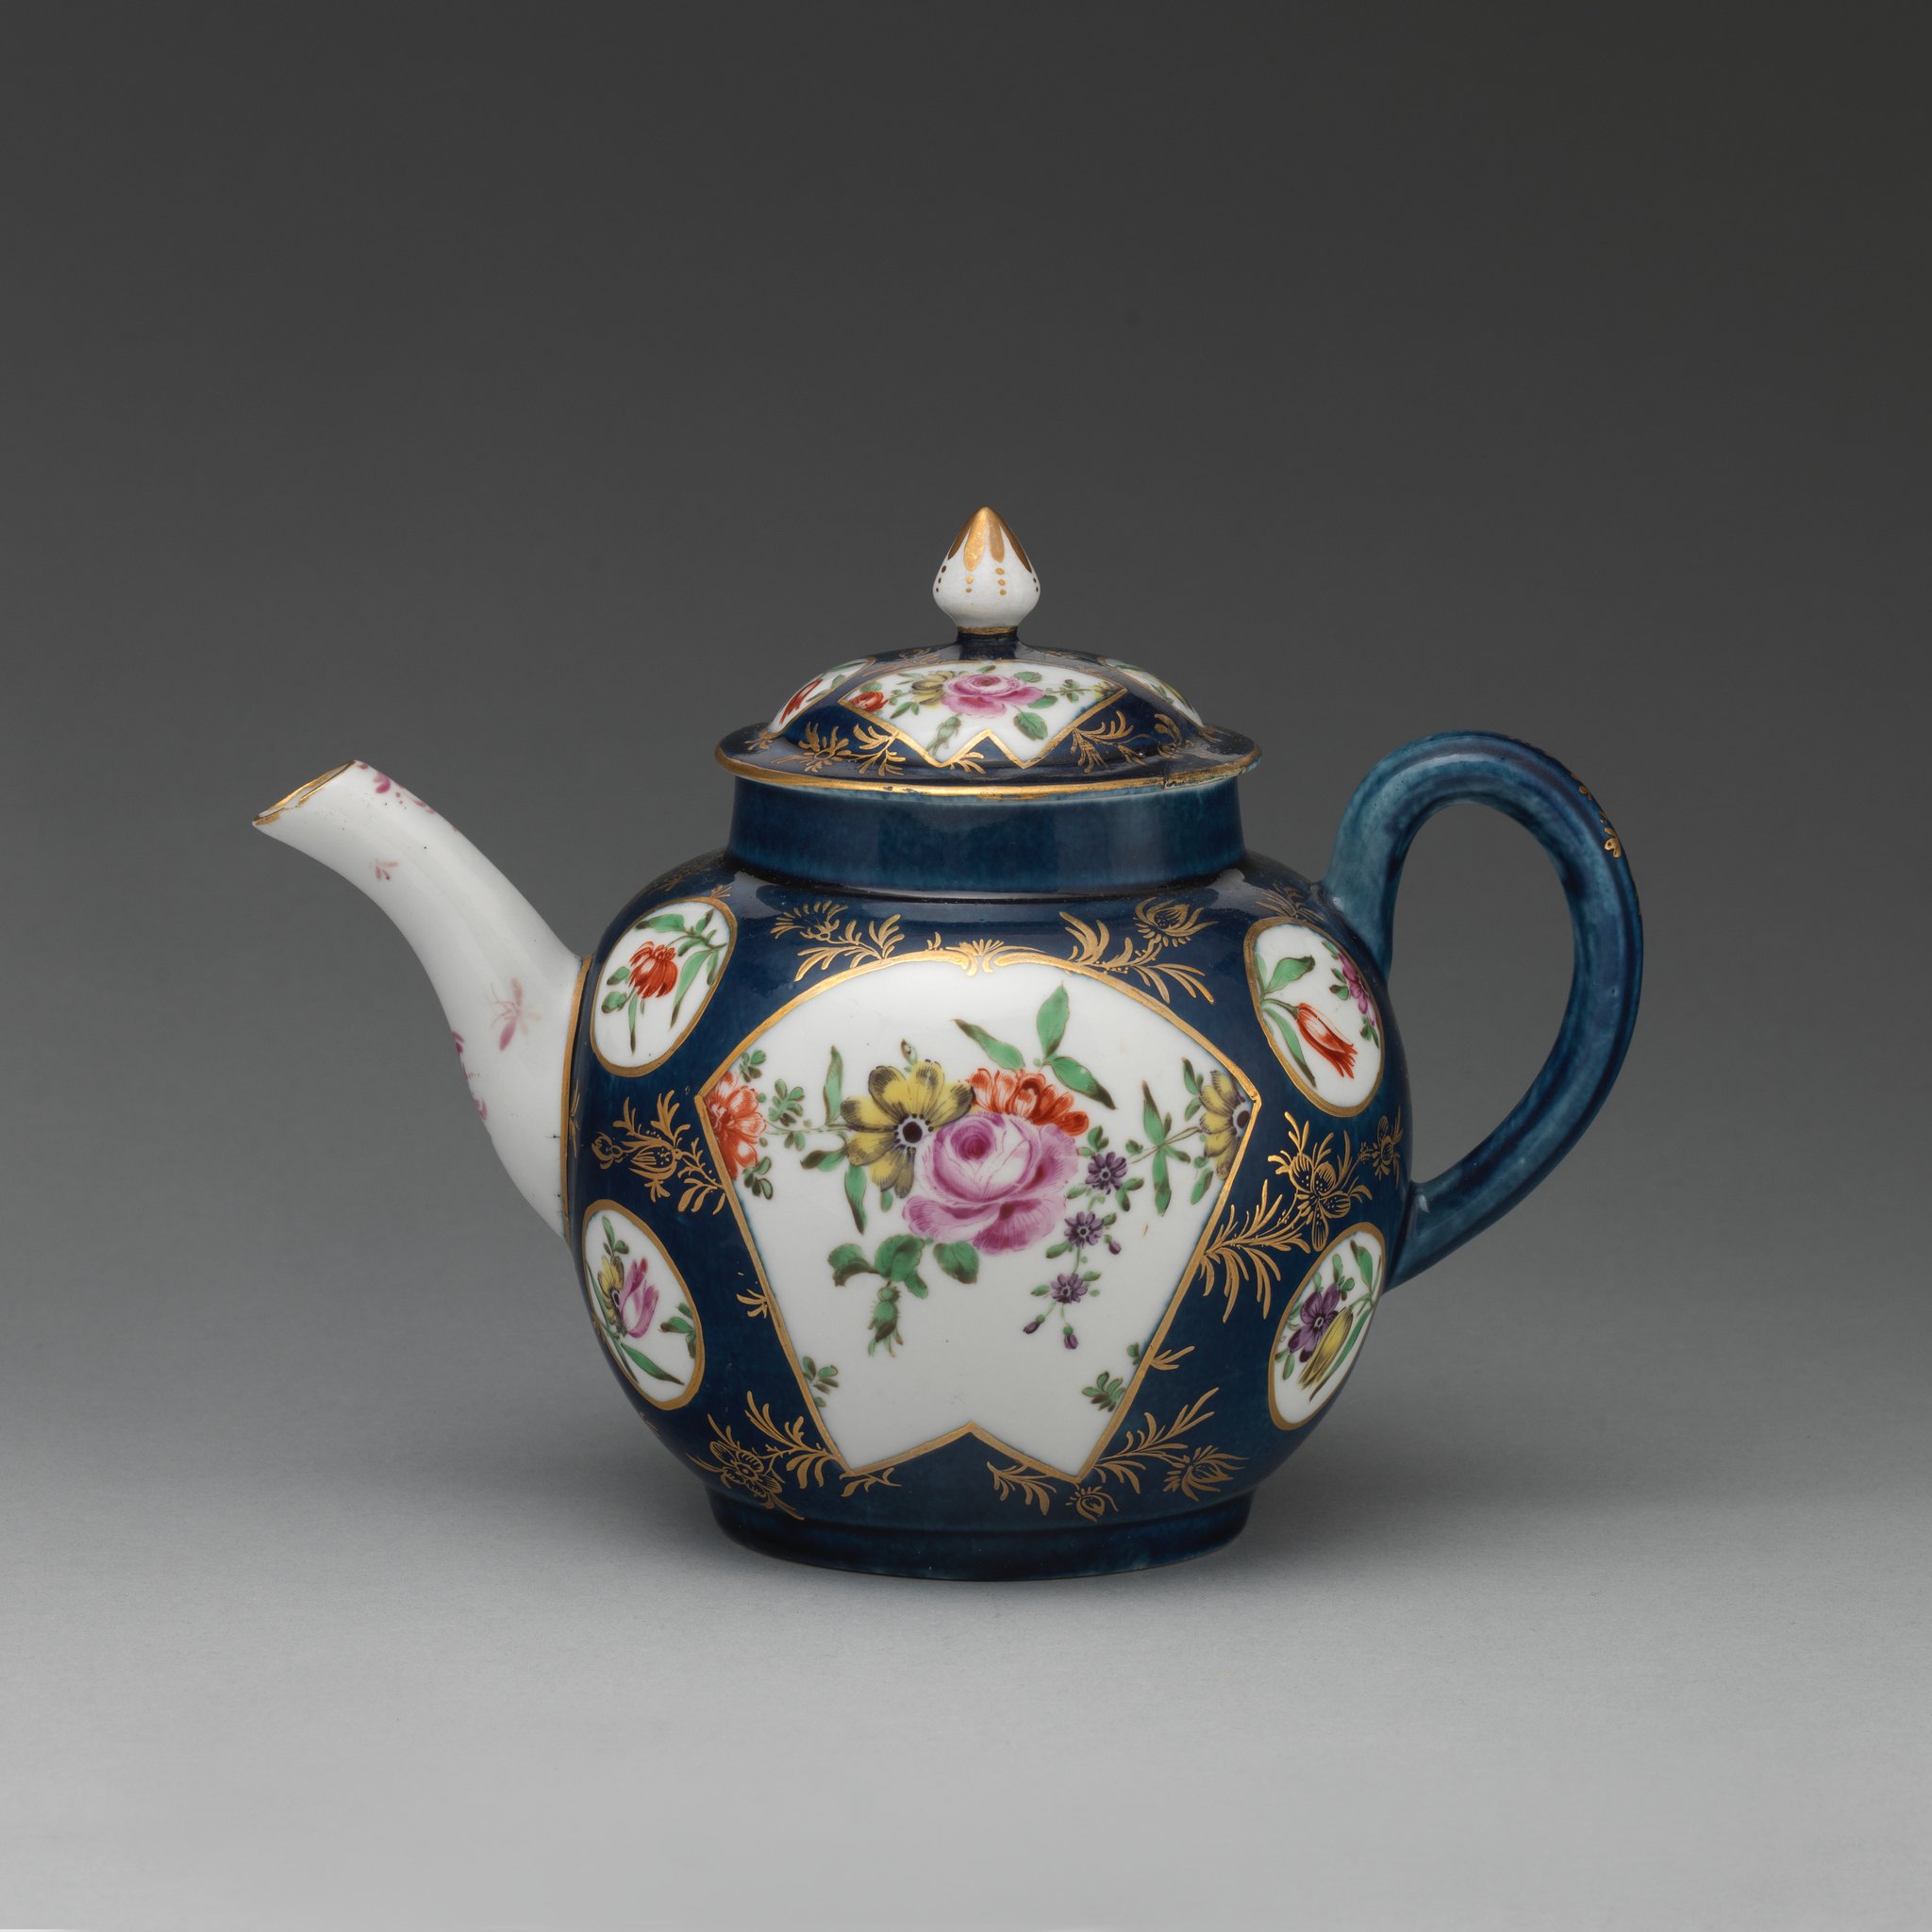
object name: teapot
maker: worcester factory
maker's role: factory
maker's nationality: british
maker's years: 1751-2008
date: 1770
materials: soft paste porcelain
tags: flowers